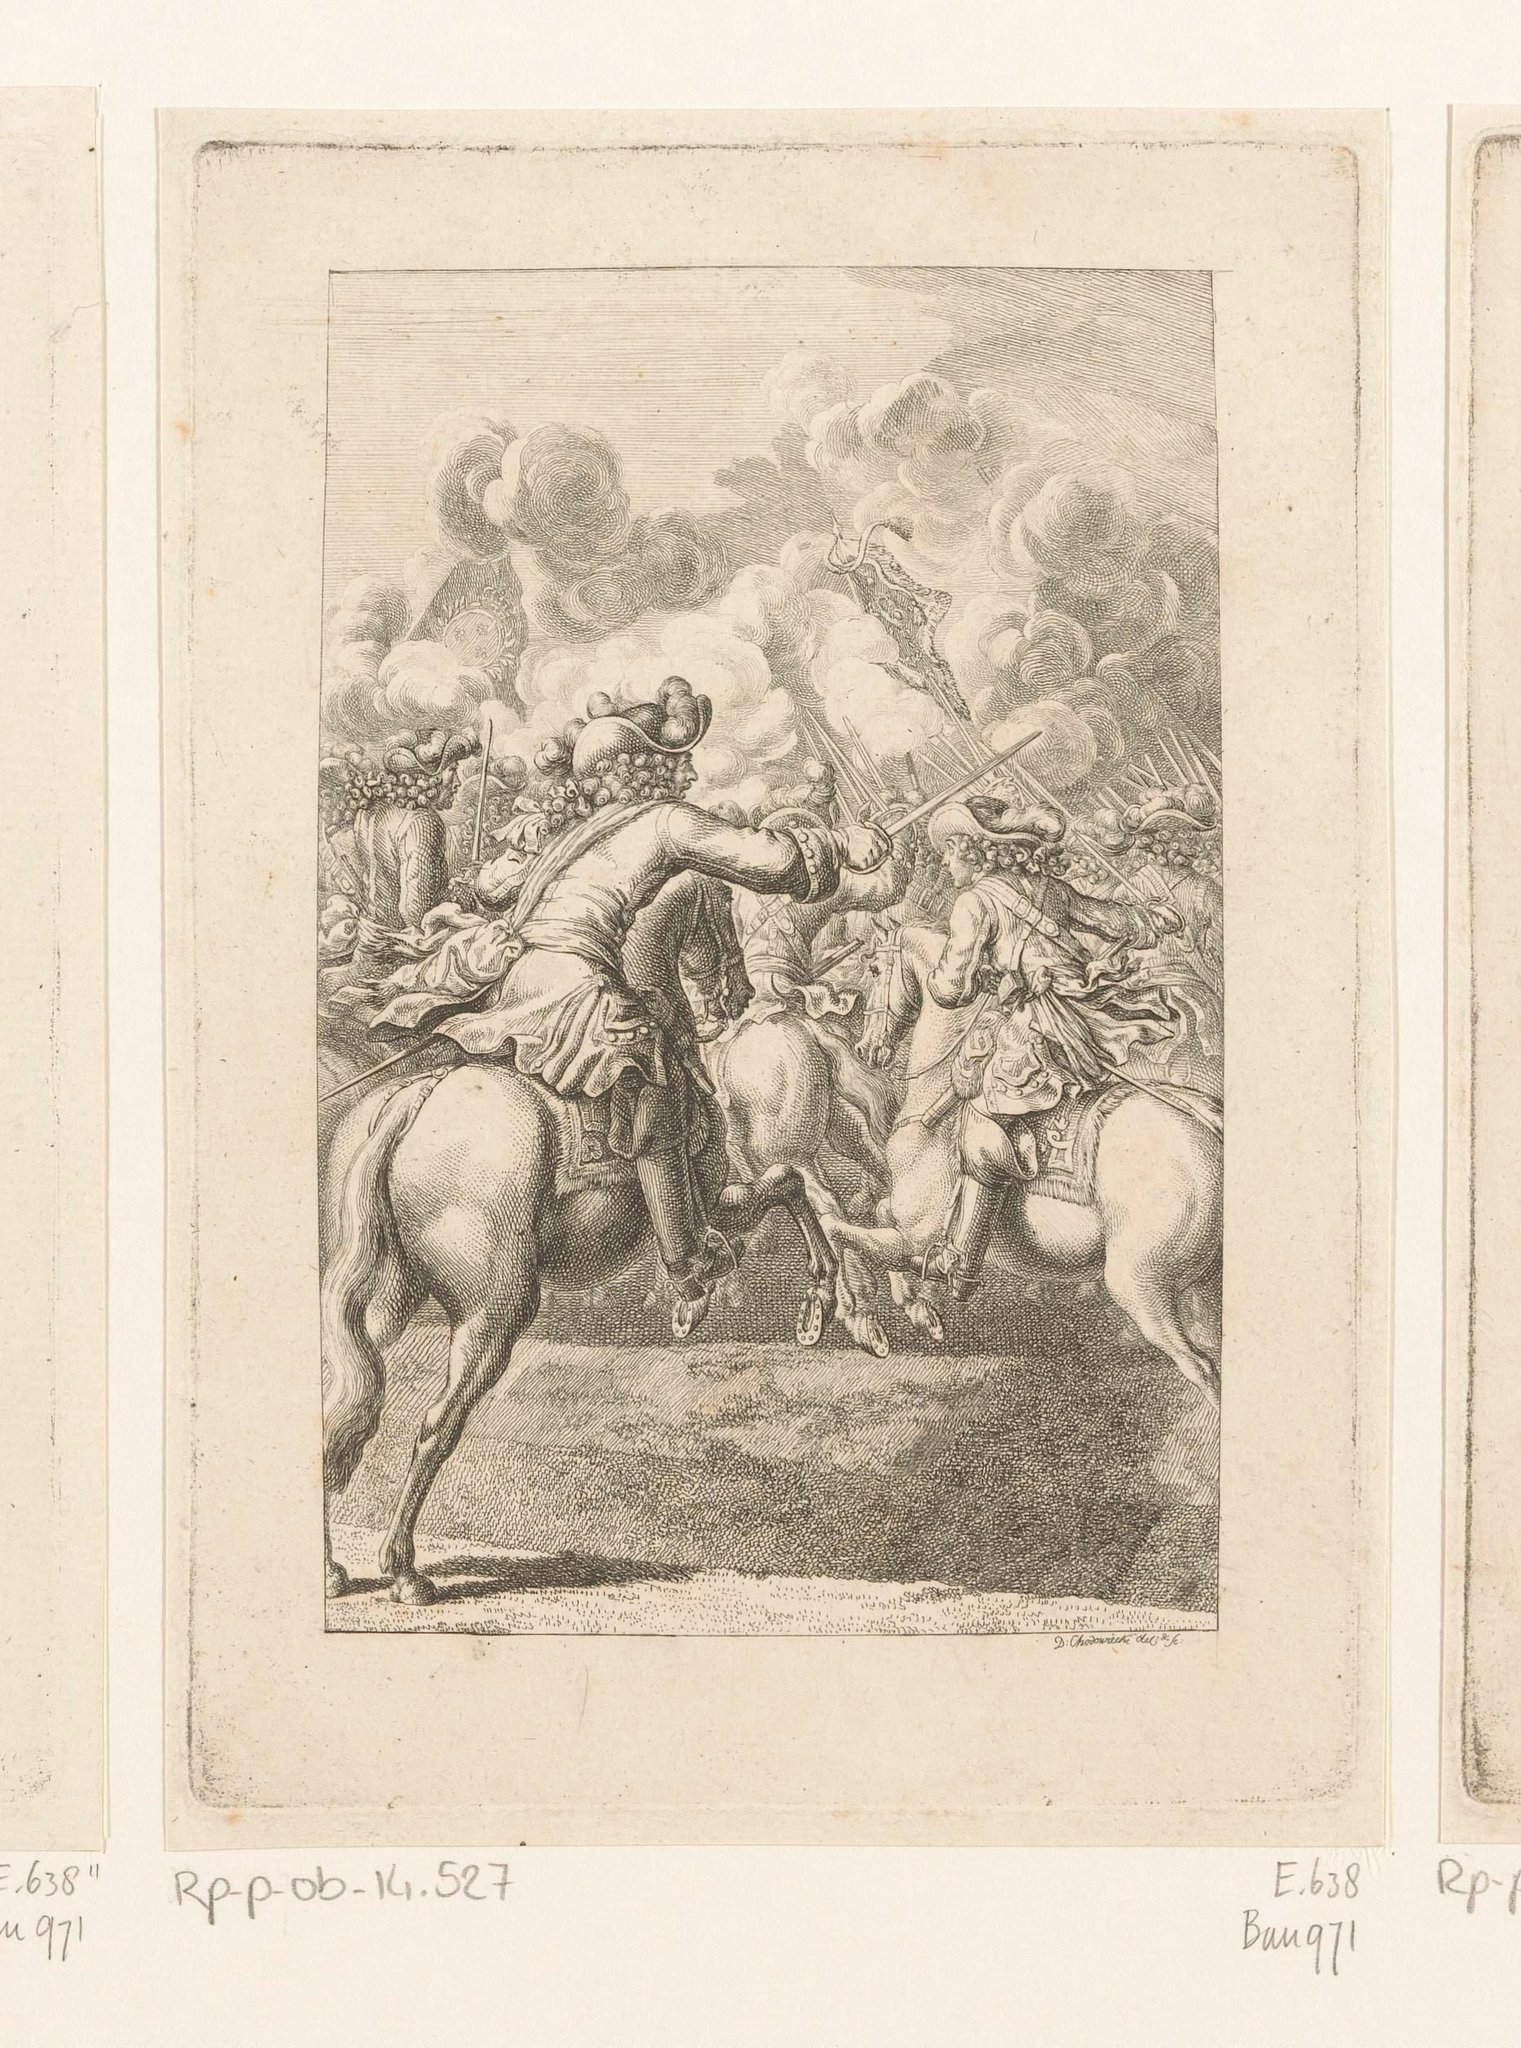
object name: print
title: Friedrich III op het slagveld tijdens de negenjarige oorlog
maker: daniel nikolaus chodowiecki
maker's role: draughtsman, print maker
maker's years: 1726-1801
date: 1790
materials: paper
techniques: etching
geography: berlin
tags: frederik willem van brandenburg (i), riding a horse, ass, or mule; rider, horseman, hacking and thrusting weapons: sword, charge ~ battle, flag, colours (as symbol of the state, etc.)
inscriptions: collector's mark: Lugt 2228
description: Prent gebruikt voor: Erman, Jean Pierre. Mémoires pour servir à l'histoire des réfugiés françois dans les états du roi. 9 dln. Berlijn: s.n., 1790, dl. 7.